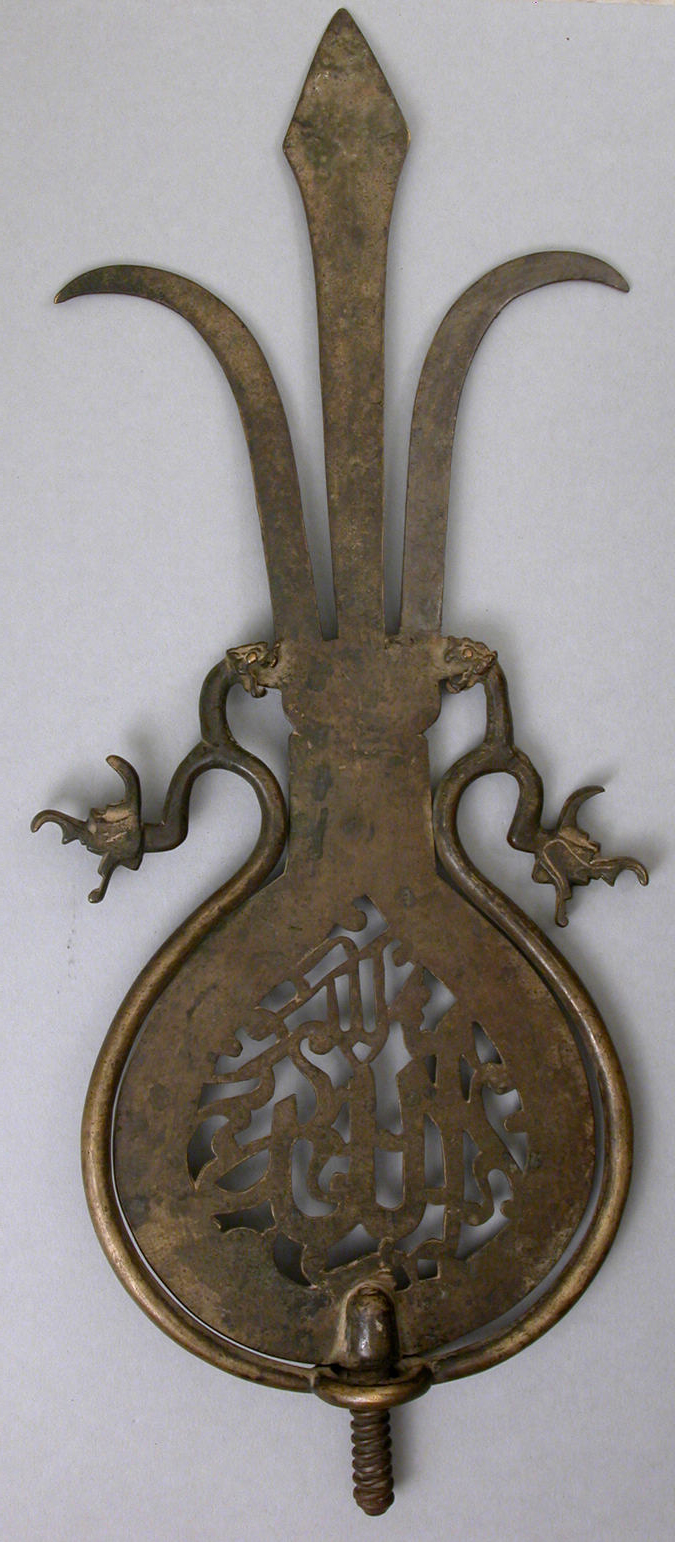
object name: finial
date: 1601-1700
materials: brass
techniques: hammering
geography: iran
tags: arabic